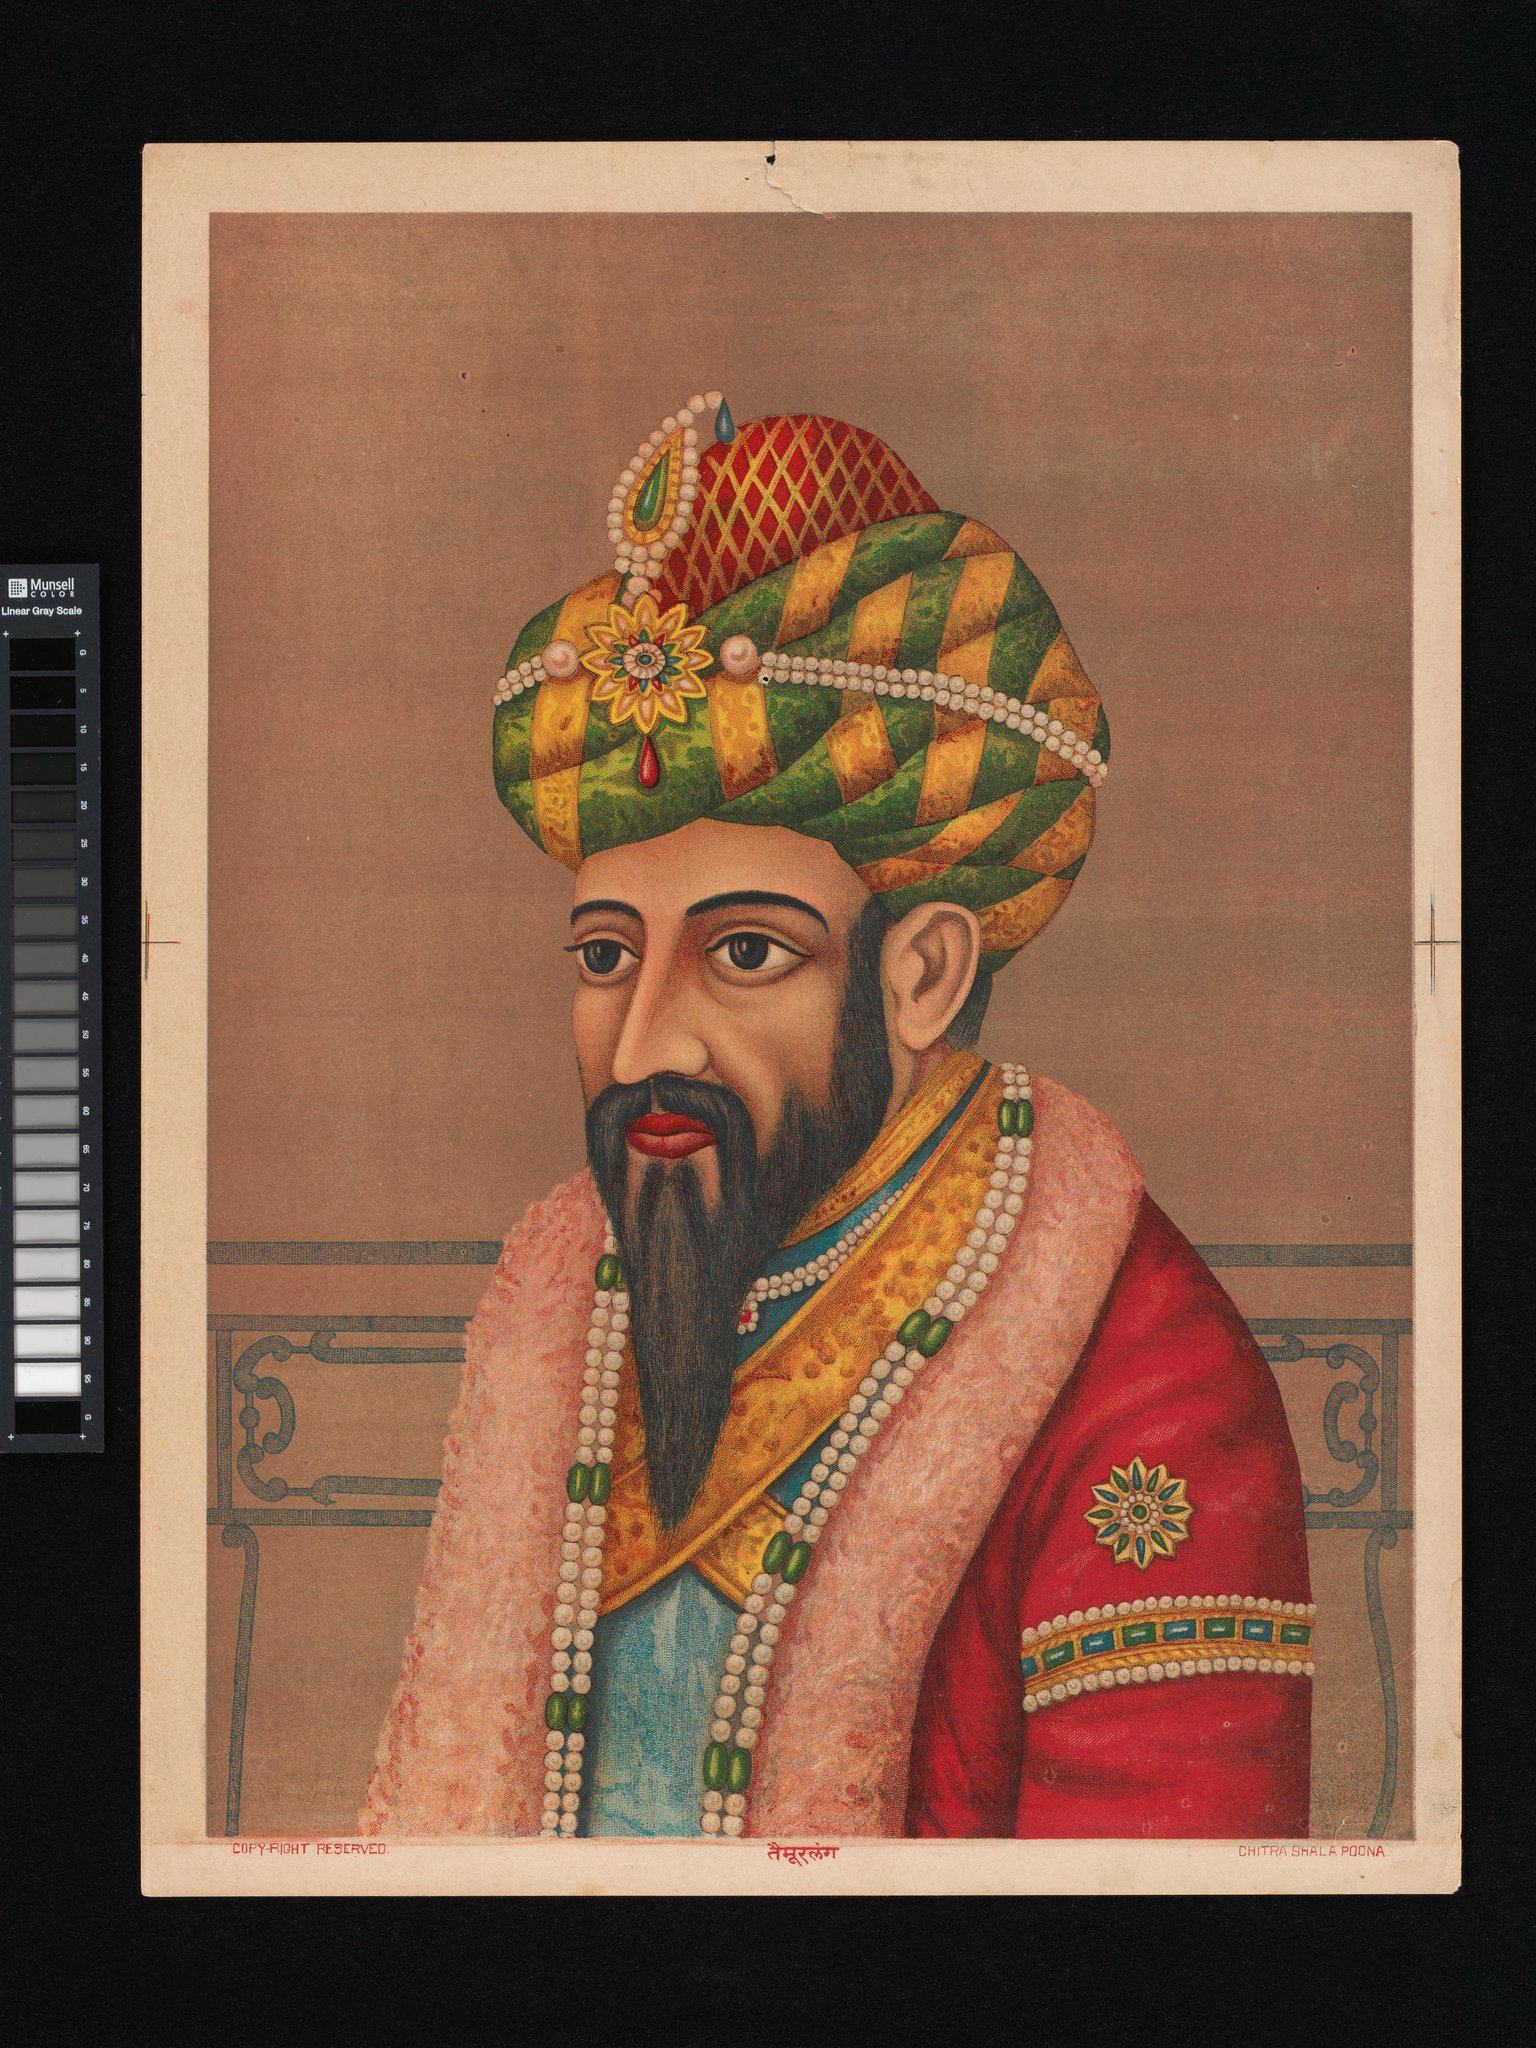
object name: print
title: Portrait of a Man with a Jeweled Turban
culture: indian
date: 1880-1889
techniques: lithograph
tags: men,portraits